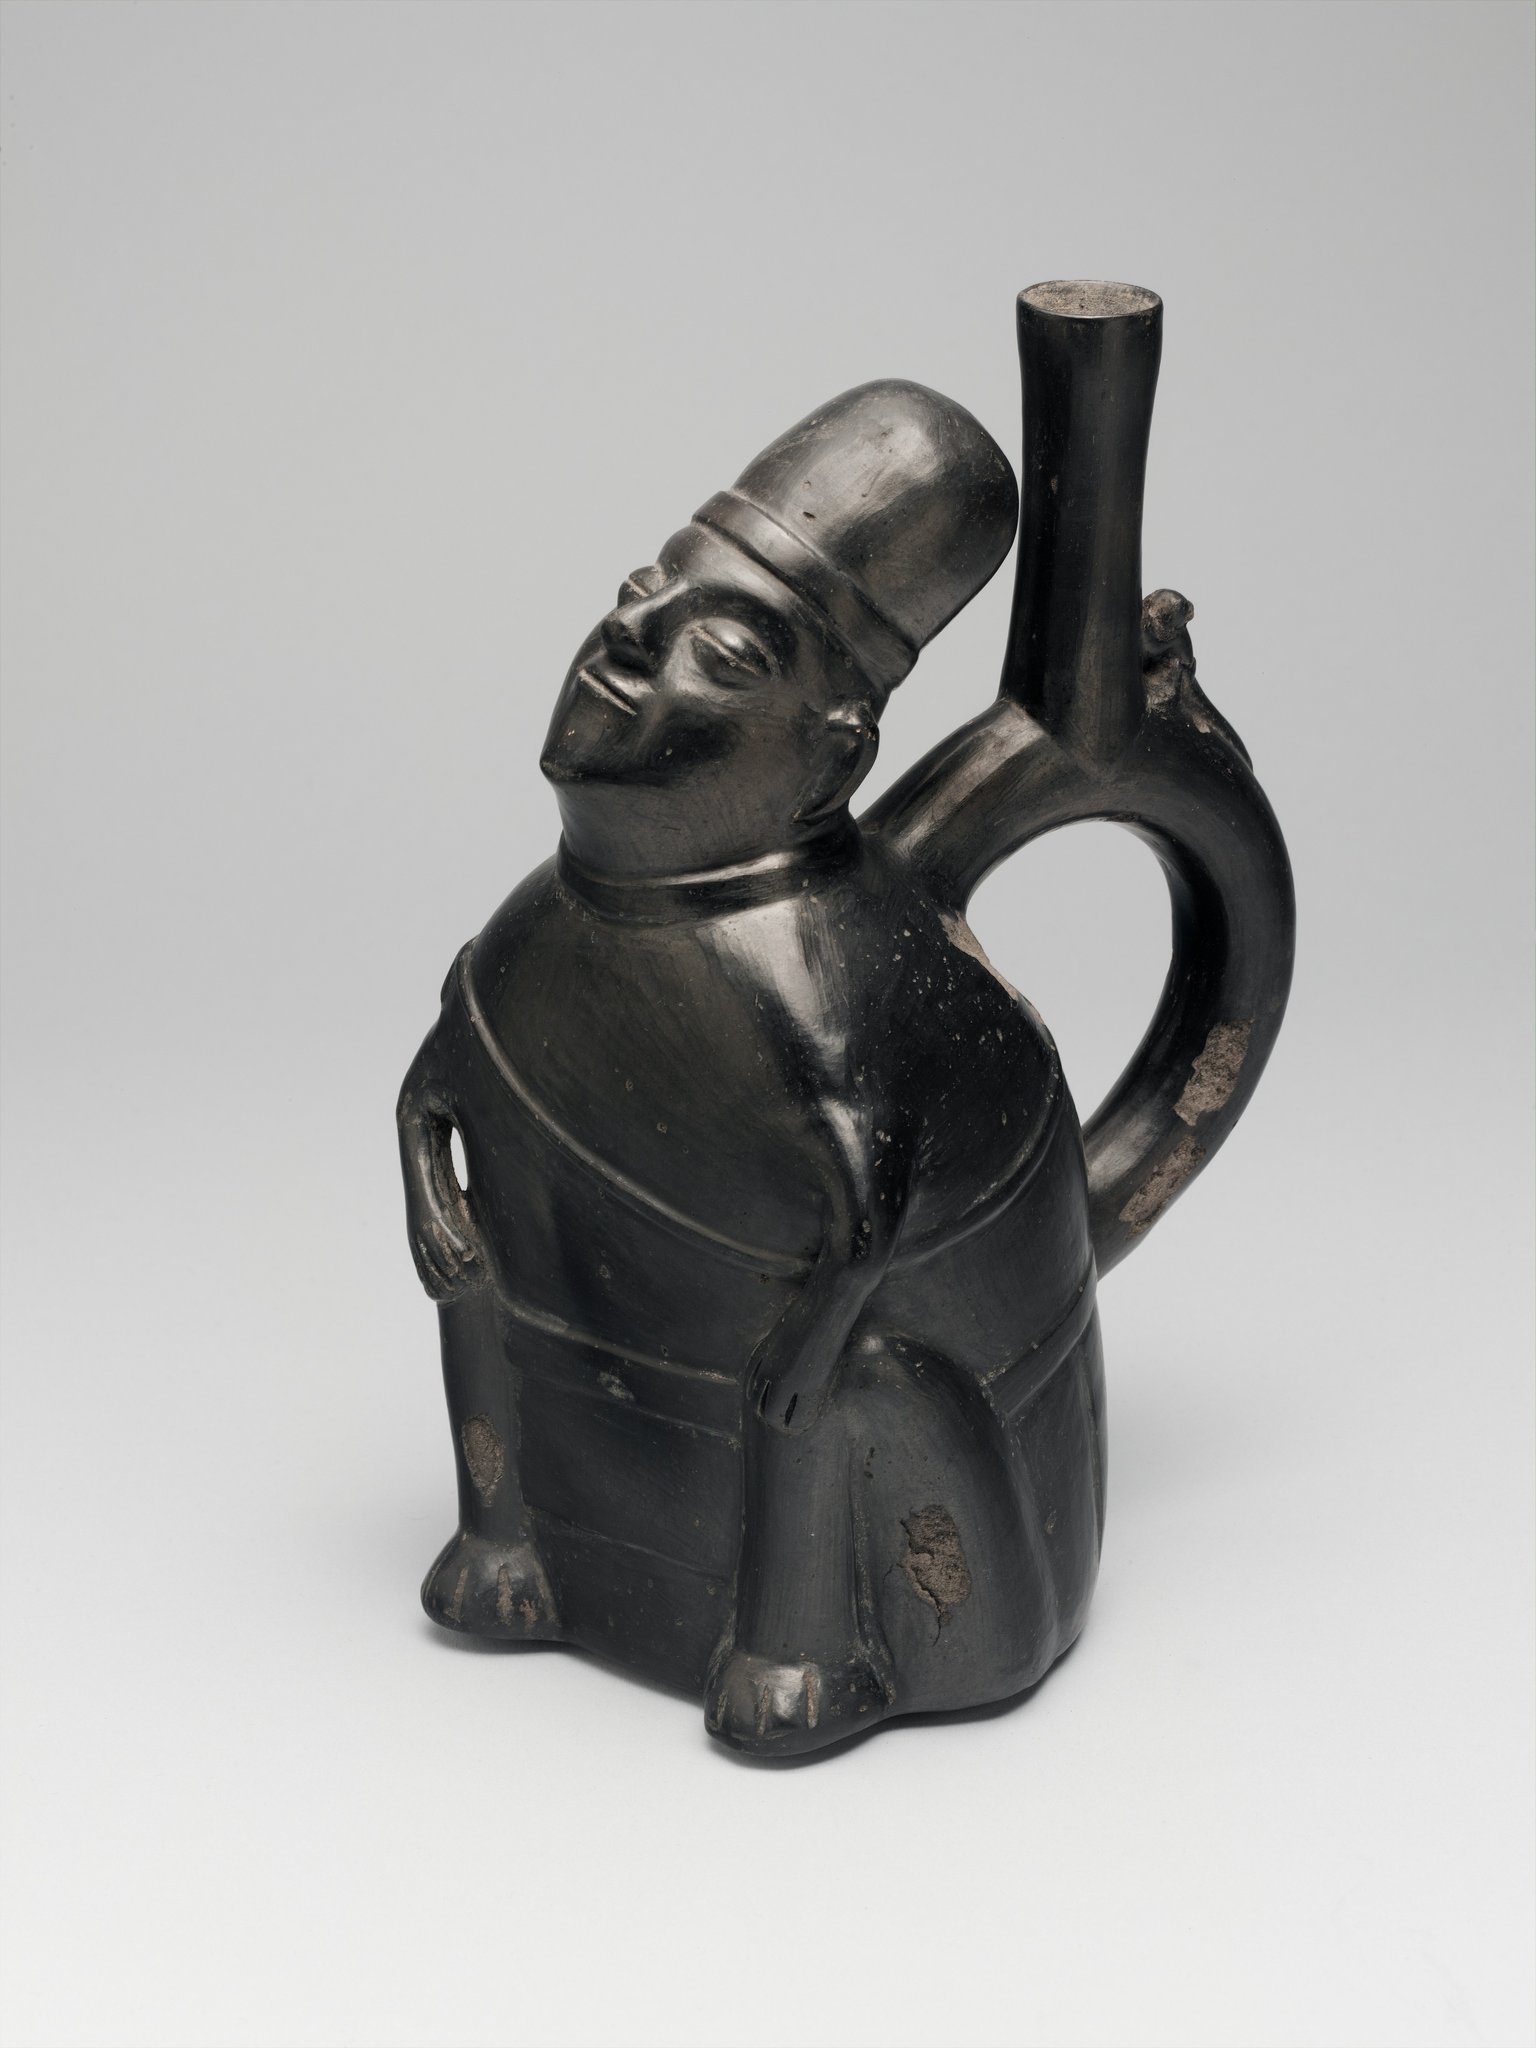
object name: bottle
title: Sleeping Figure Bottle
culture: chimú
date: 1101-1500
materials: ceramic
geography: peru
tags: sleeping,men